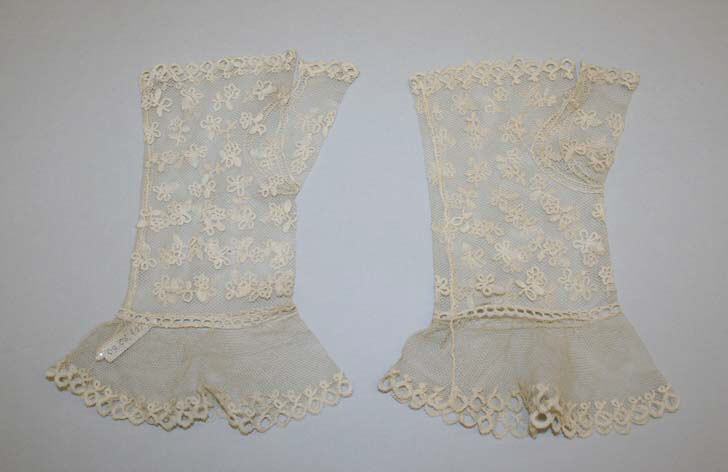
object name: mitt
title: Mitts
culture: british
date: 1801-1900